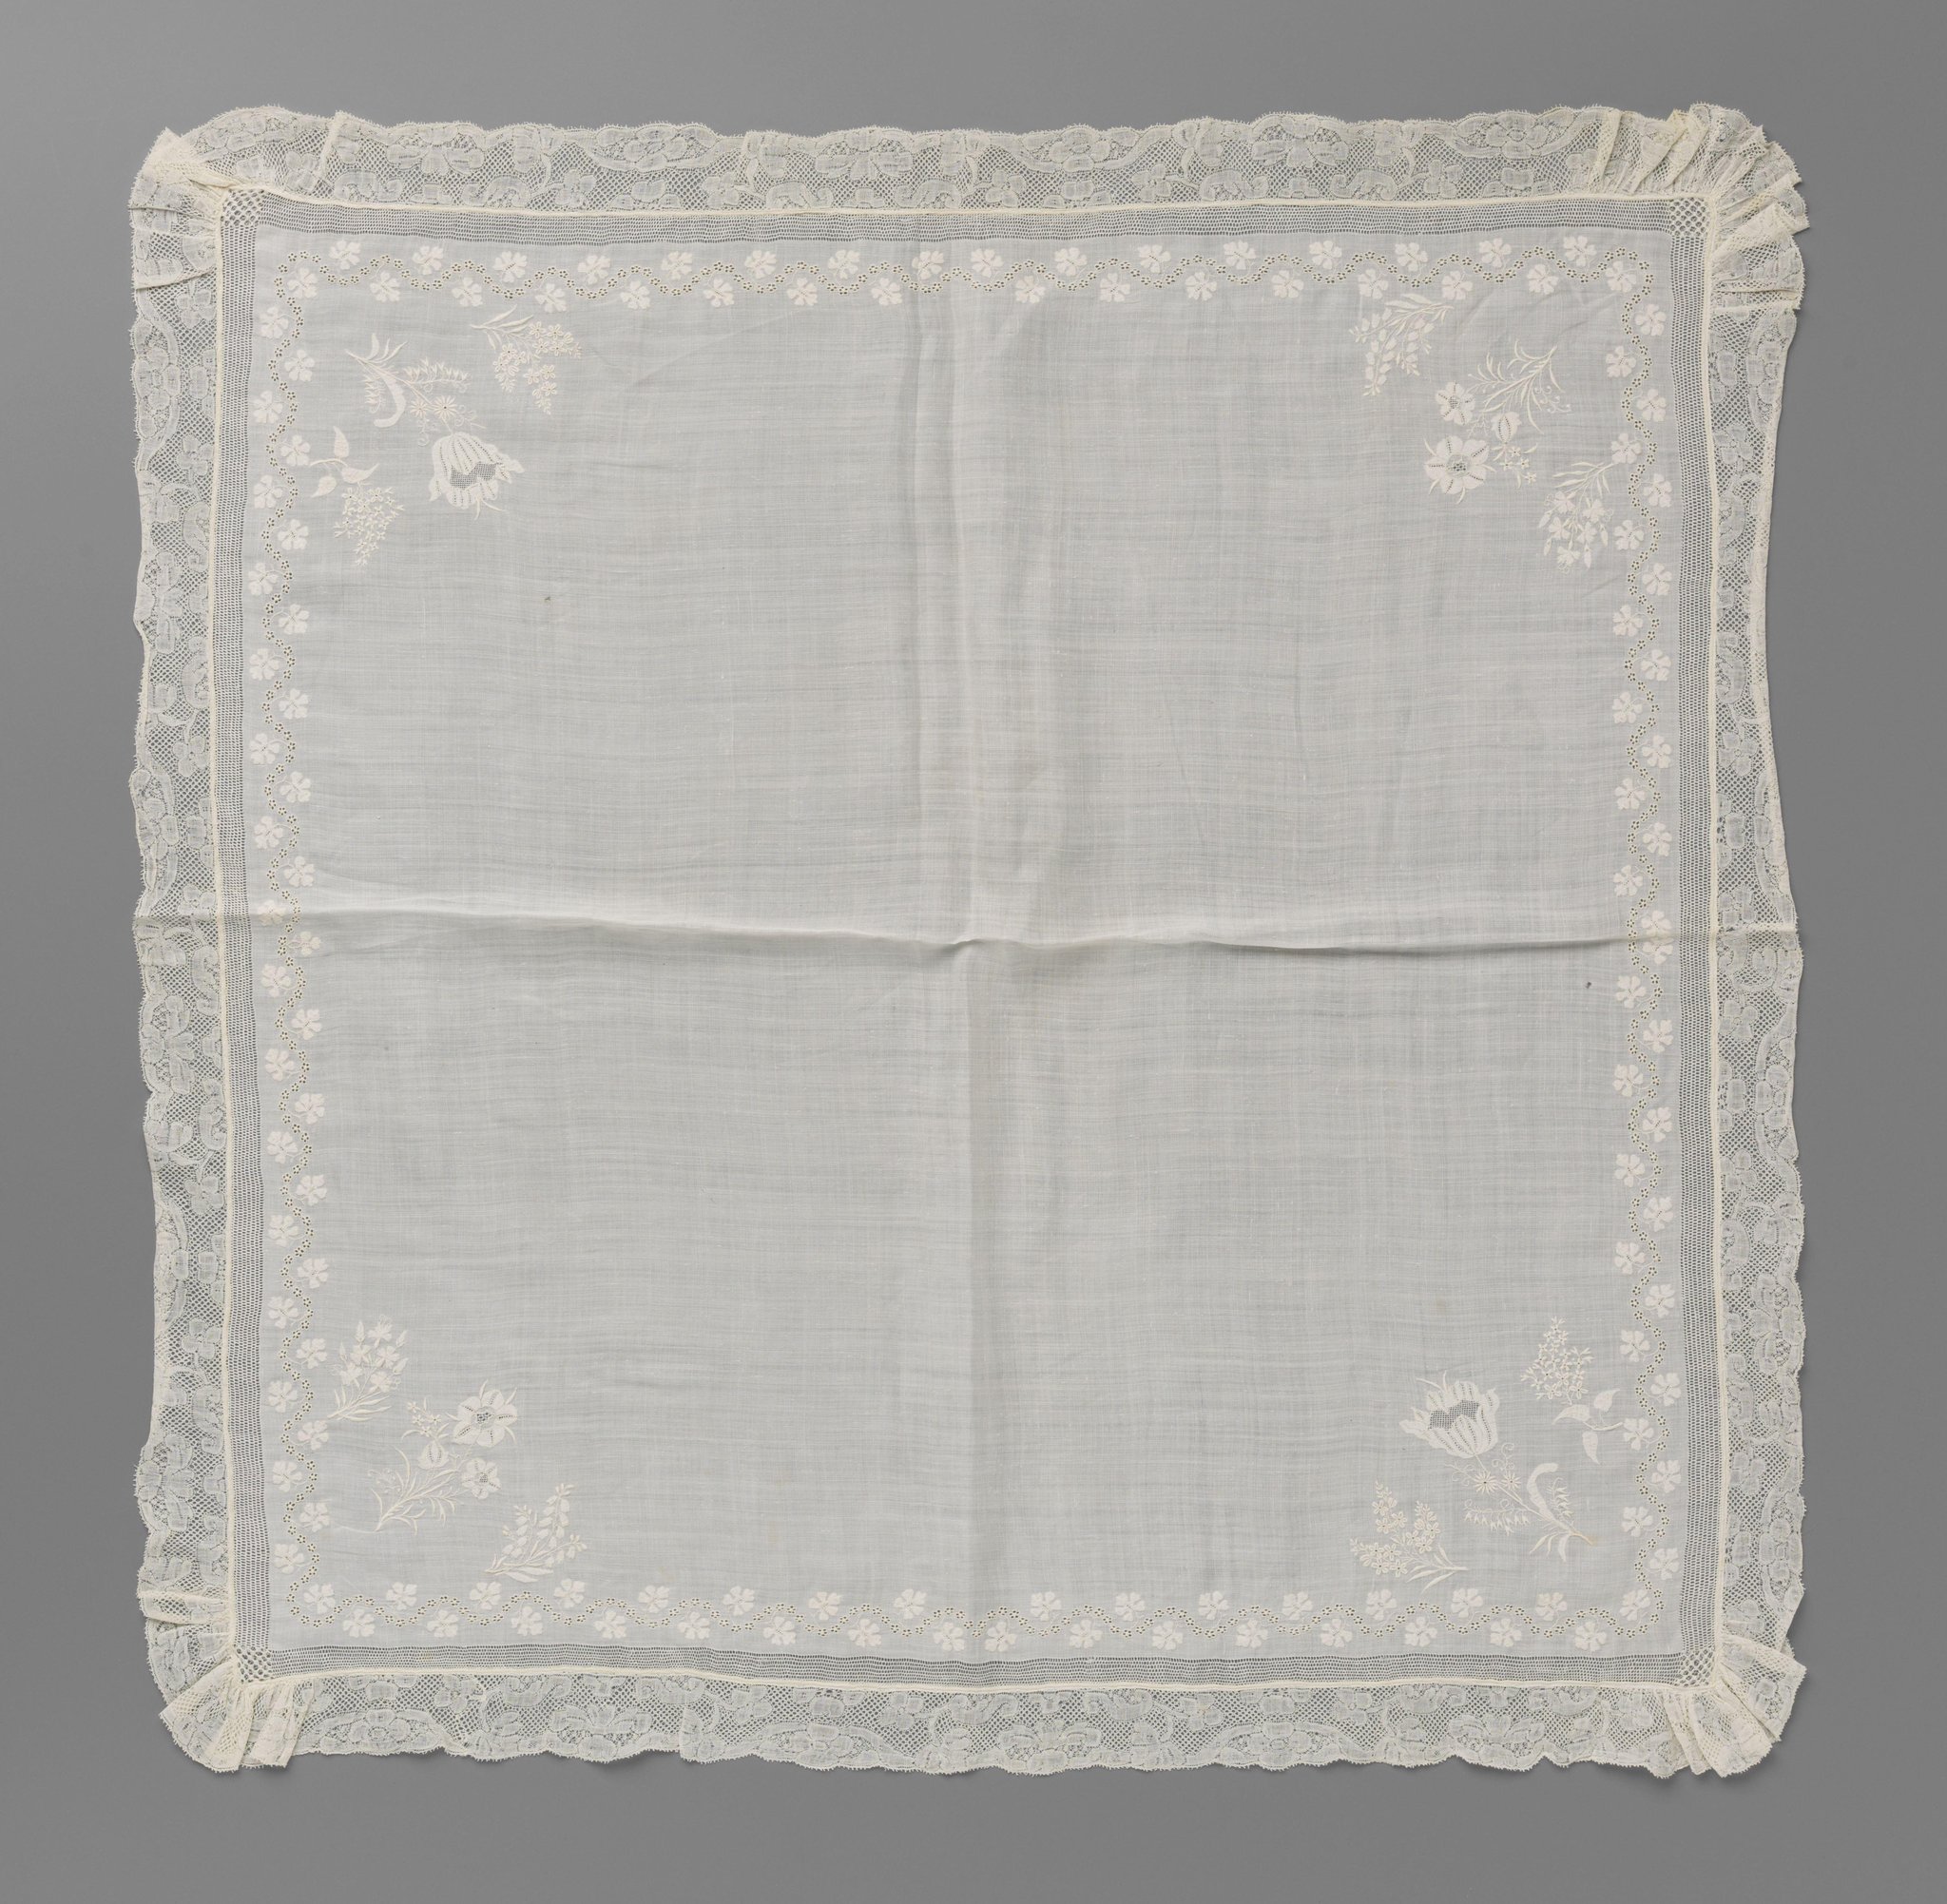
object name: handkerchief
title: Zakdoek van batist met drie bloemtakken in elke hoek gemaakt in schaduwwerk en rondom een rand Vlaanderse kant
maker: Anonymous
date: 1840-1860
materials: cotton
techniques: lace, embroidered, shadow quilted, weave, embroidery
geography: western europe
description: Zakdoek van naturelkleurige batist met borduurwerk en rondom een rand kloskant: Vlaanderse kant. Het borduurwerk bevindt zich in de hoeken en langs de randen. In elke hoek staan drie bloemtakken, geflankeerd door twee kleinere. In twee hoeken een grote kelkbloem tussen takken met vergeet-mij-nietjes. In de andere hoeken een grote rozetbloem tussen fijnere takken met anjers. De schuin tegenovergestelde hoeken zijn gelijk. Langs de gehele zijde loopt een regelmatig golvende slinger van opengewerkte vergeet-mij-nietjes en wingerdbladeren. De rand kloskant is langs de zijden glad en in de hoeken gerimpeld aan de zakdoek genaaid. Het heeft een zich herhalend patroon met twee brede symmetrische composities. De ene compositie bestaat langs de onderzijde uit een rozetbloem onder een boogje. De andere compositie bestaat langs de onderzijde uit een wolkje waaruit een hartvormige bloem ontspringt tussen twee bladeren. De composities worden gecompleteerd door een voluutblad langs de bovenzijde van de strook, waaruit een gespleten tak naar beneden wijst, met een waaiervormige bloem en een rozetbloem. De motieven zijn gemaakt in linnenslag met opengewerkte randjes en enige uitsparingen. De motieven zijn met elkaar verbonden door een vijfgaatjesgrond. Als siergrond is een sneeuwvlokkengrond gebruikt. De schulpenrand langs de onderzijde komt voort uit het patroon is afgewerkt met picots.